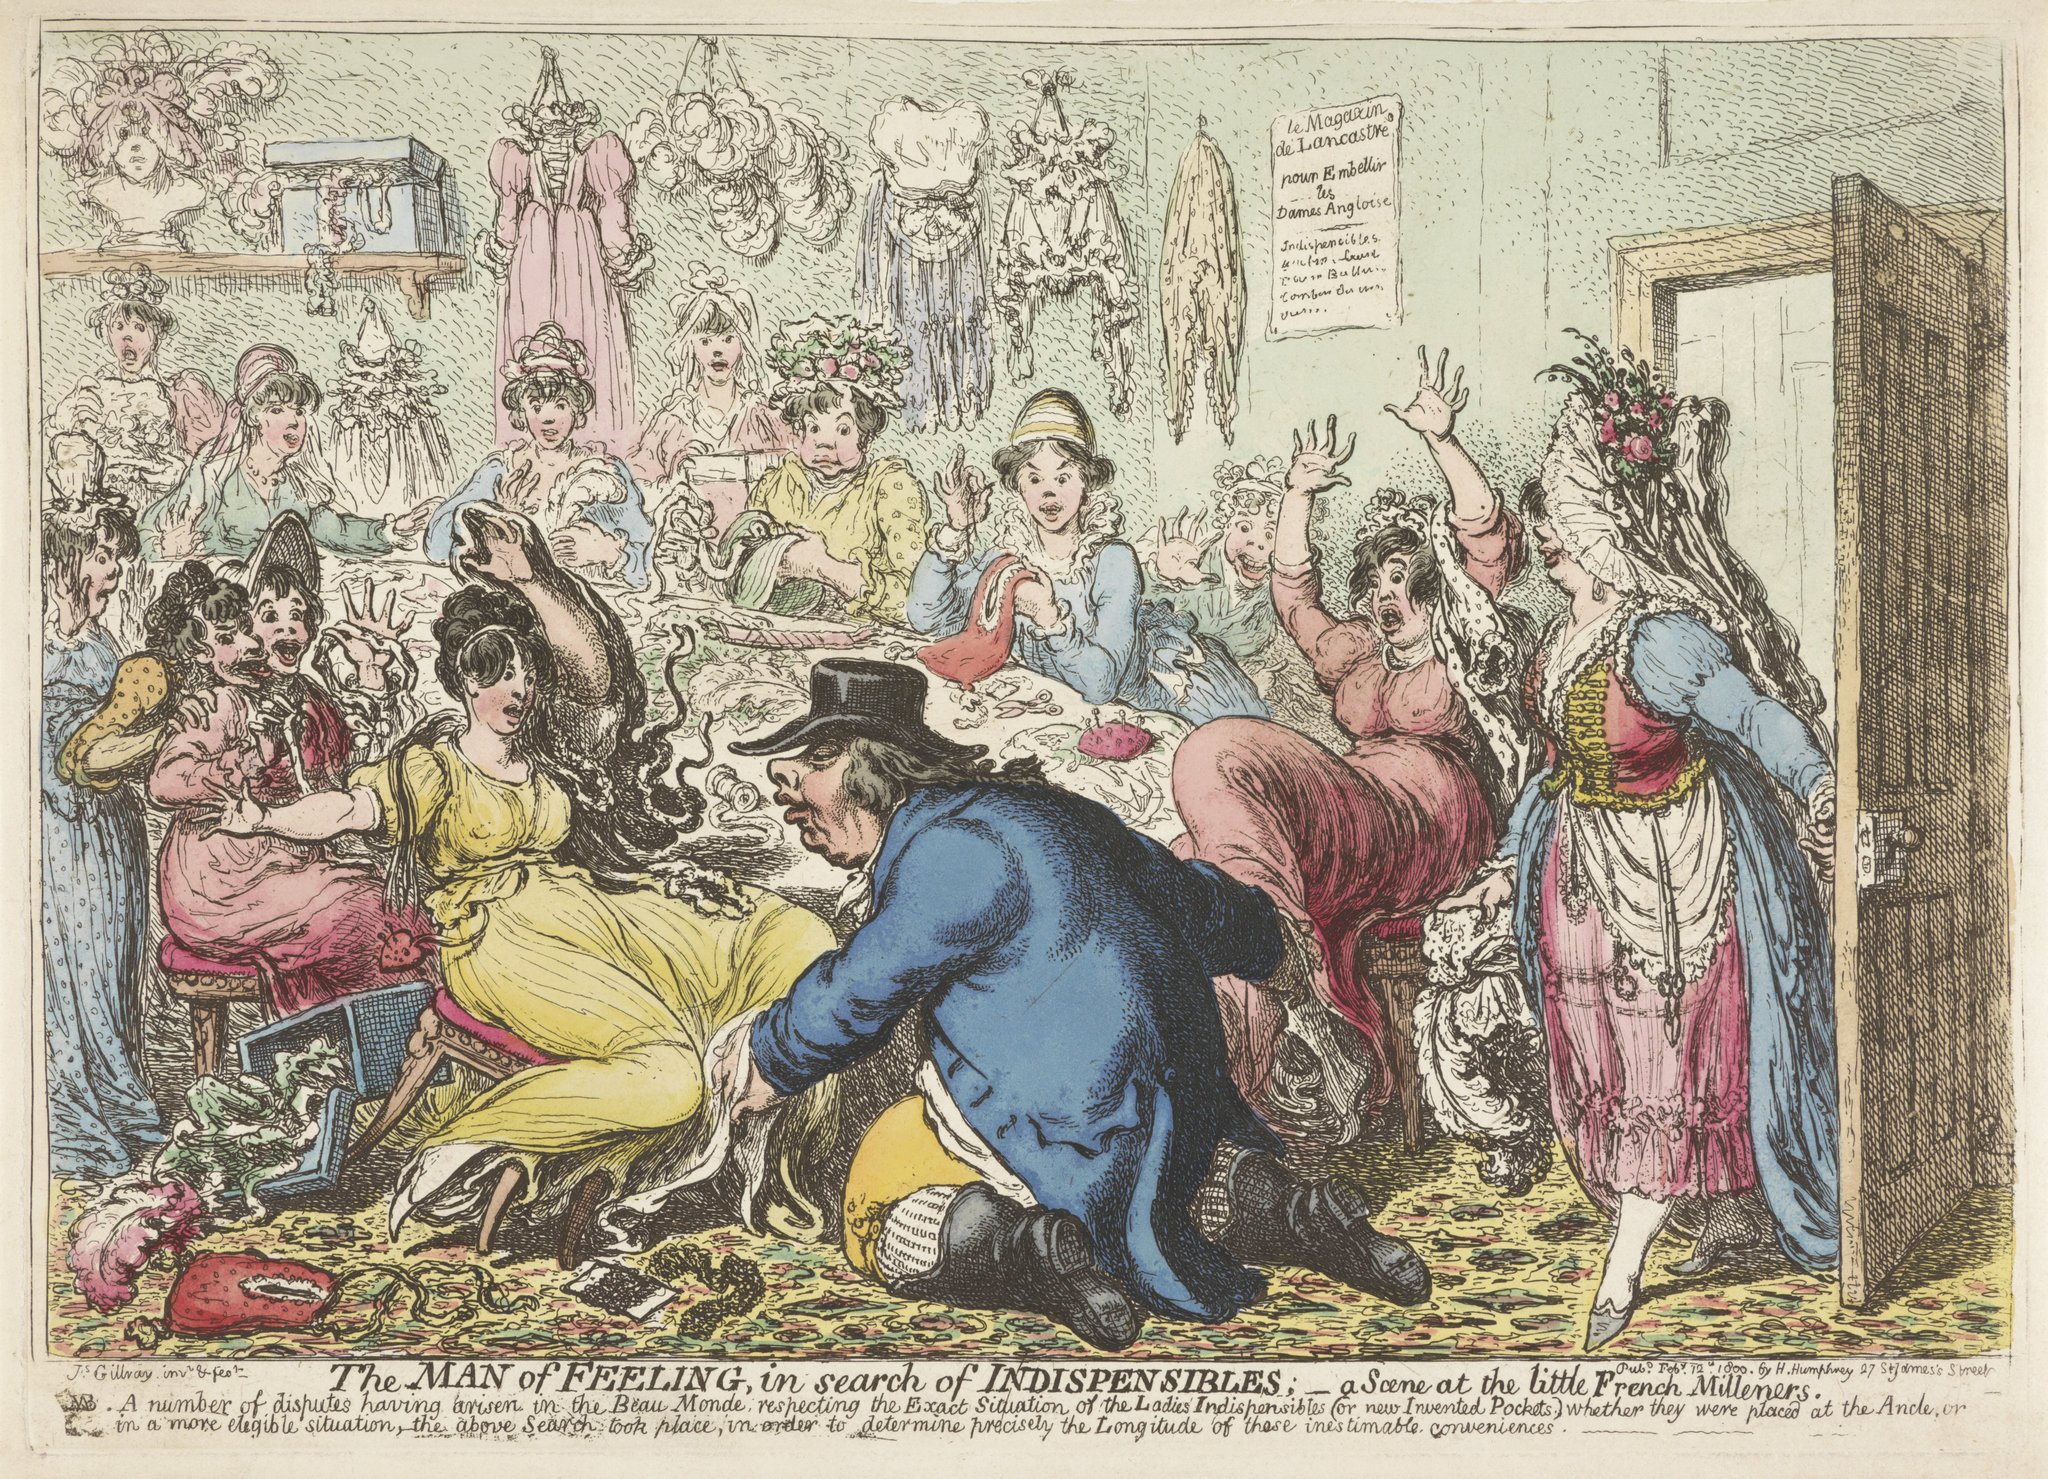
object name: print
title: The Man of Feeling, in search of Indispensibles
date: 1800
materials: paper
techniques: etching, hand coloring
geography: london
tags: the hague, william v (prince of orange), purse, money-bag (+ sewing ~ home making of clothes), bag (reticule) (+ women's clothes), woman-chaser, sewing, london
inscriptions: collector's mark: Lugt 2228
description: At the heart of the mayhem in this milliner’s workshop, the Dutch stadtholder’s profile is instantly recognizable. The printmaker capitalized on both the prince’s reputation as a ladies’ man and his poor eyesight. Feeling his way up the skirts of a shocked seamstress, the stadtholder attempts to discover the precise location of her ‘indispensible’ – a kind of pouch women wore beneath their gowns.